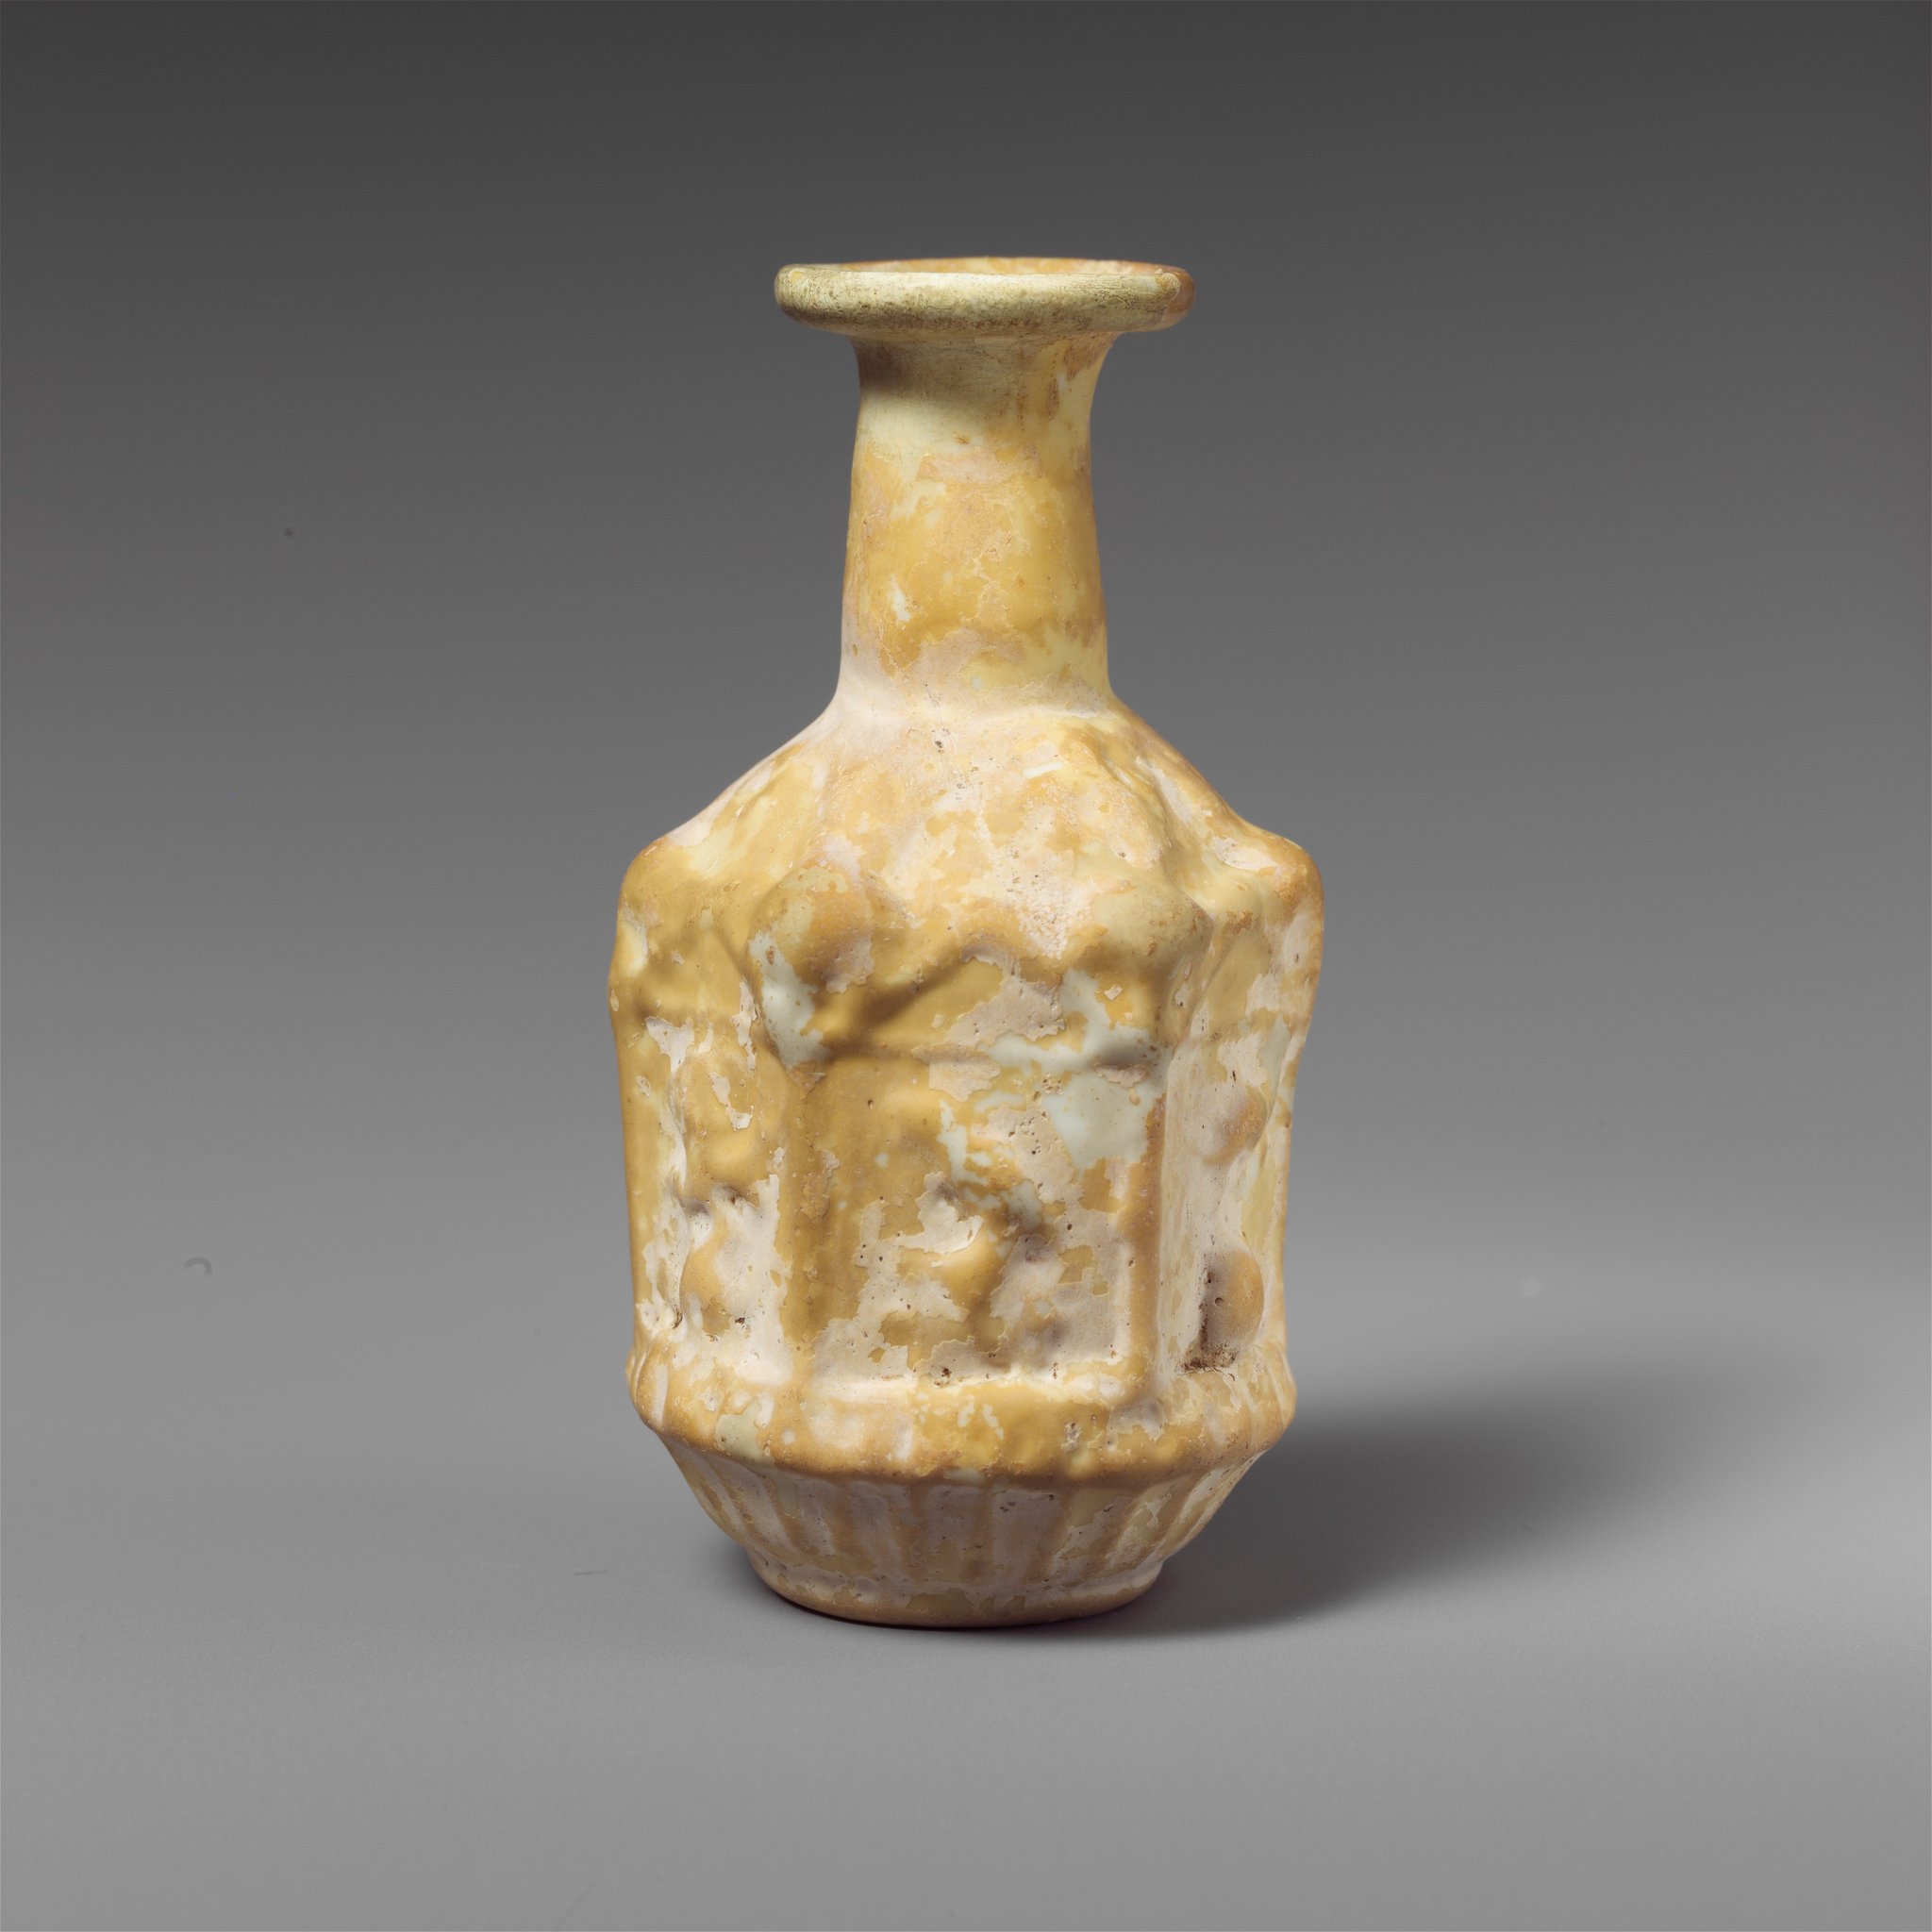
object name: bottle, hexagonal, with bird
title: Glass hexagonal bottle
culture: roman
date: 25-50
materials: glass